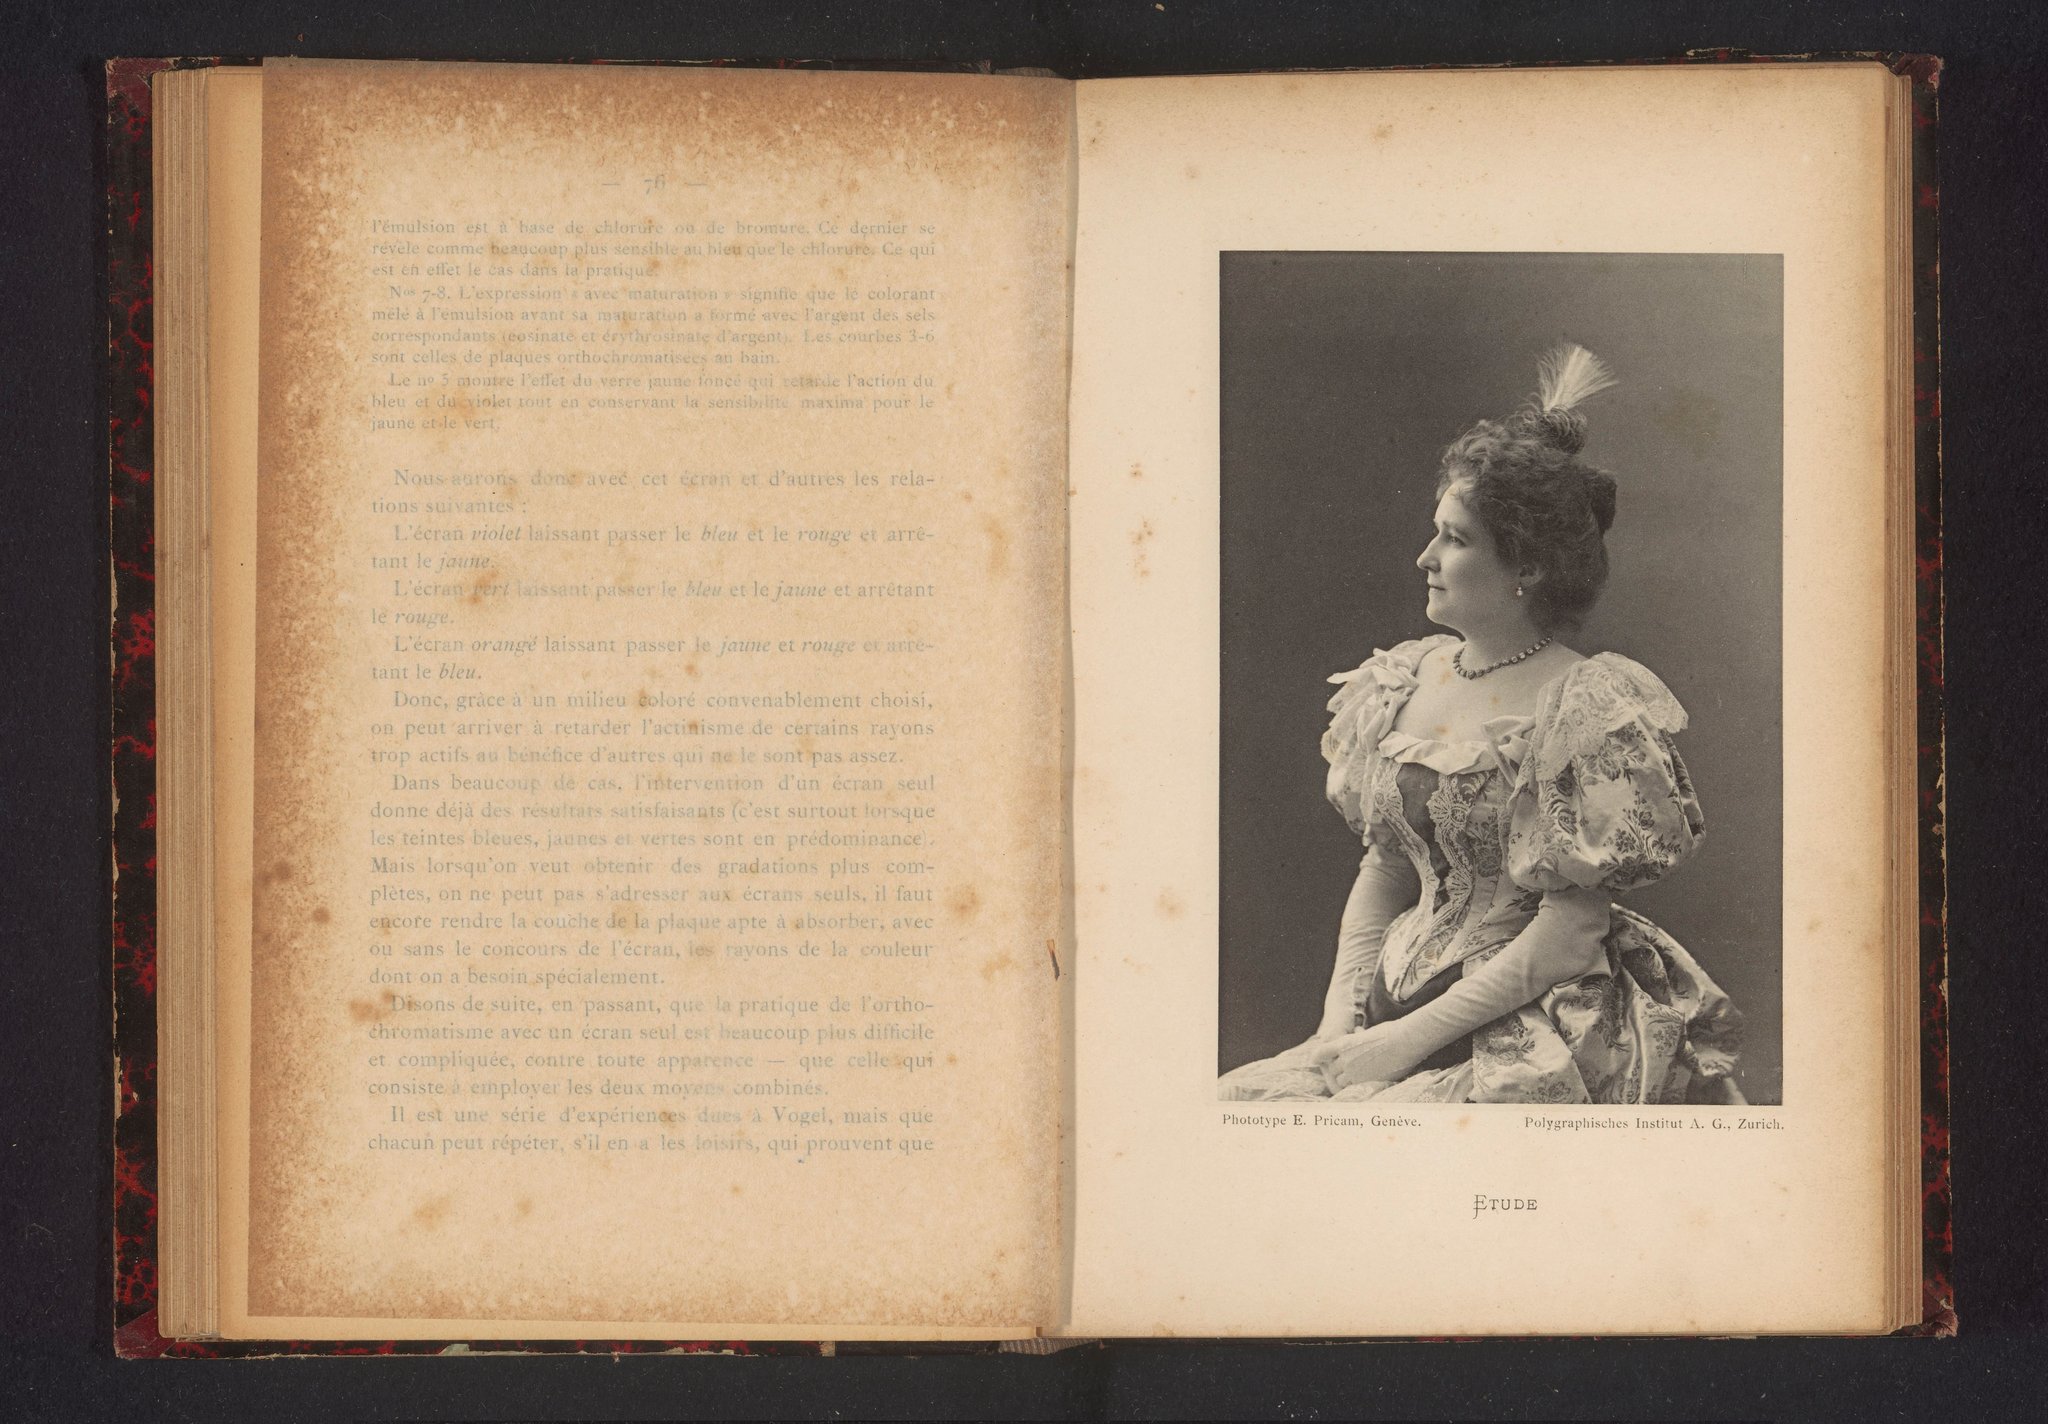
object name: page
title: Portret van een onbekende vrouw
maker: emile pricam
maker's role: fotograaf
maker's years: 1844-1919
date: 1892-1897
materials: paper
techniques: photograph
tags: historical persons not known by name - bb - woman